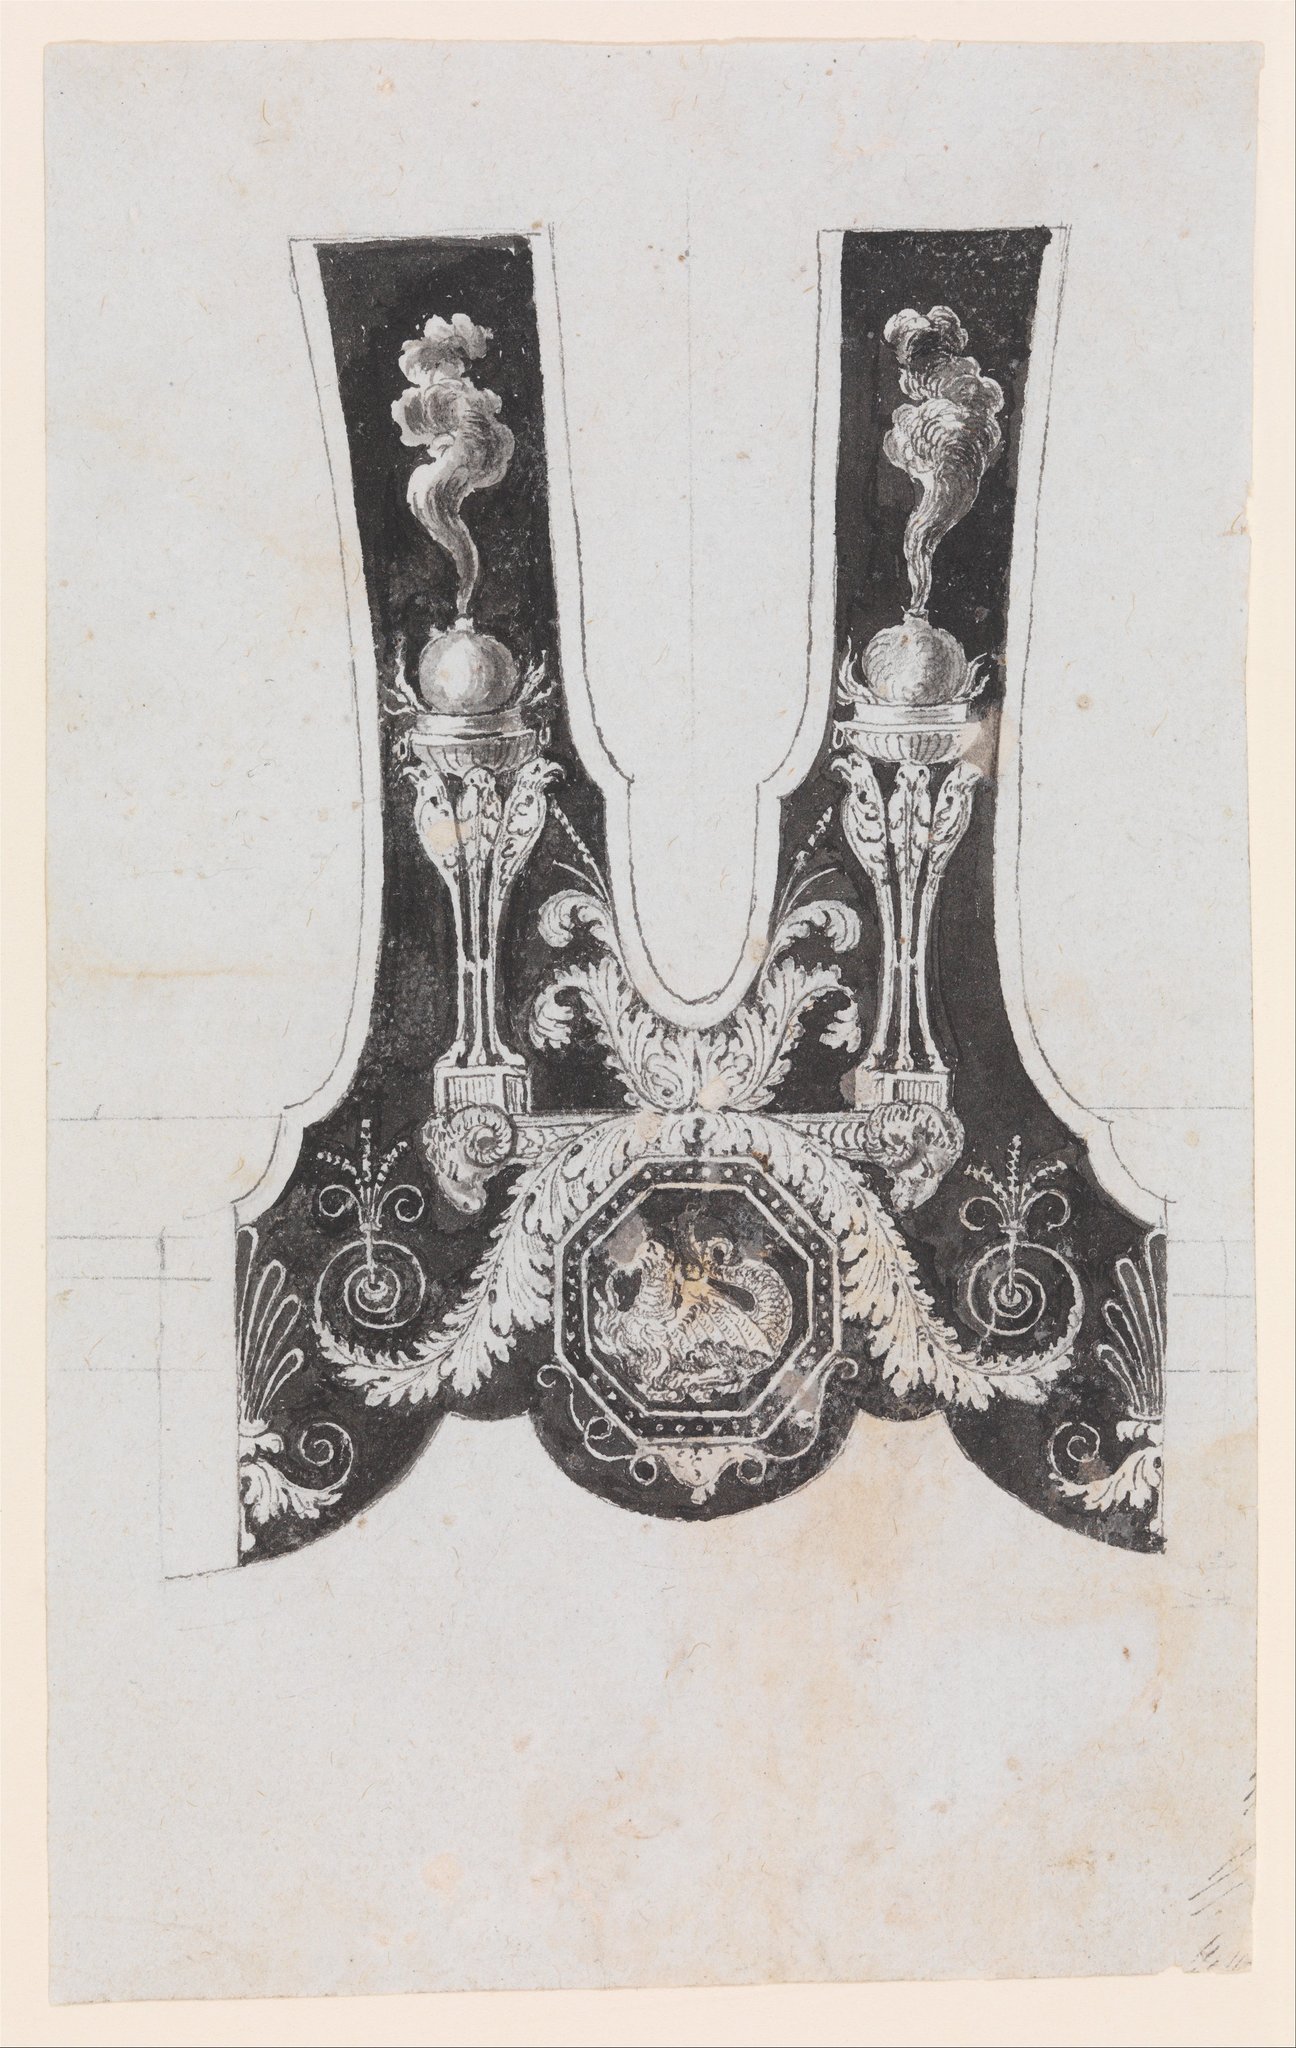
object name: drawing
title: Design for the Decoration of the Surround of the Barrel Tang of a Firearm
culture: french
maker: nicolas noël boutet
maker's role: designer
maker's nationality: french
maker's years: 1761-1833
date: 1795-1805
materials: ink, paper, pencil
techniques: wash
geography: france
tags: birds,dragons